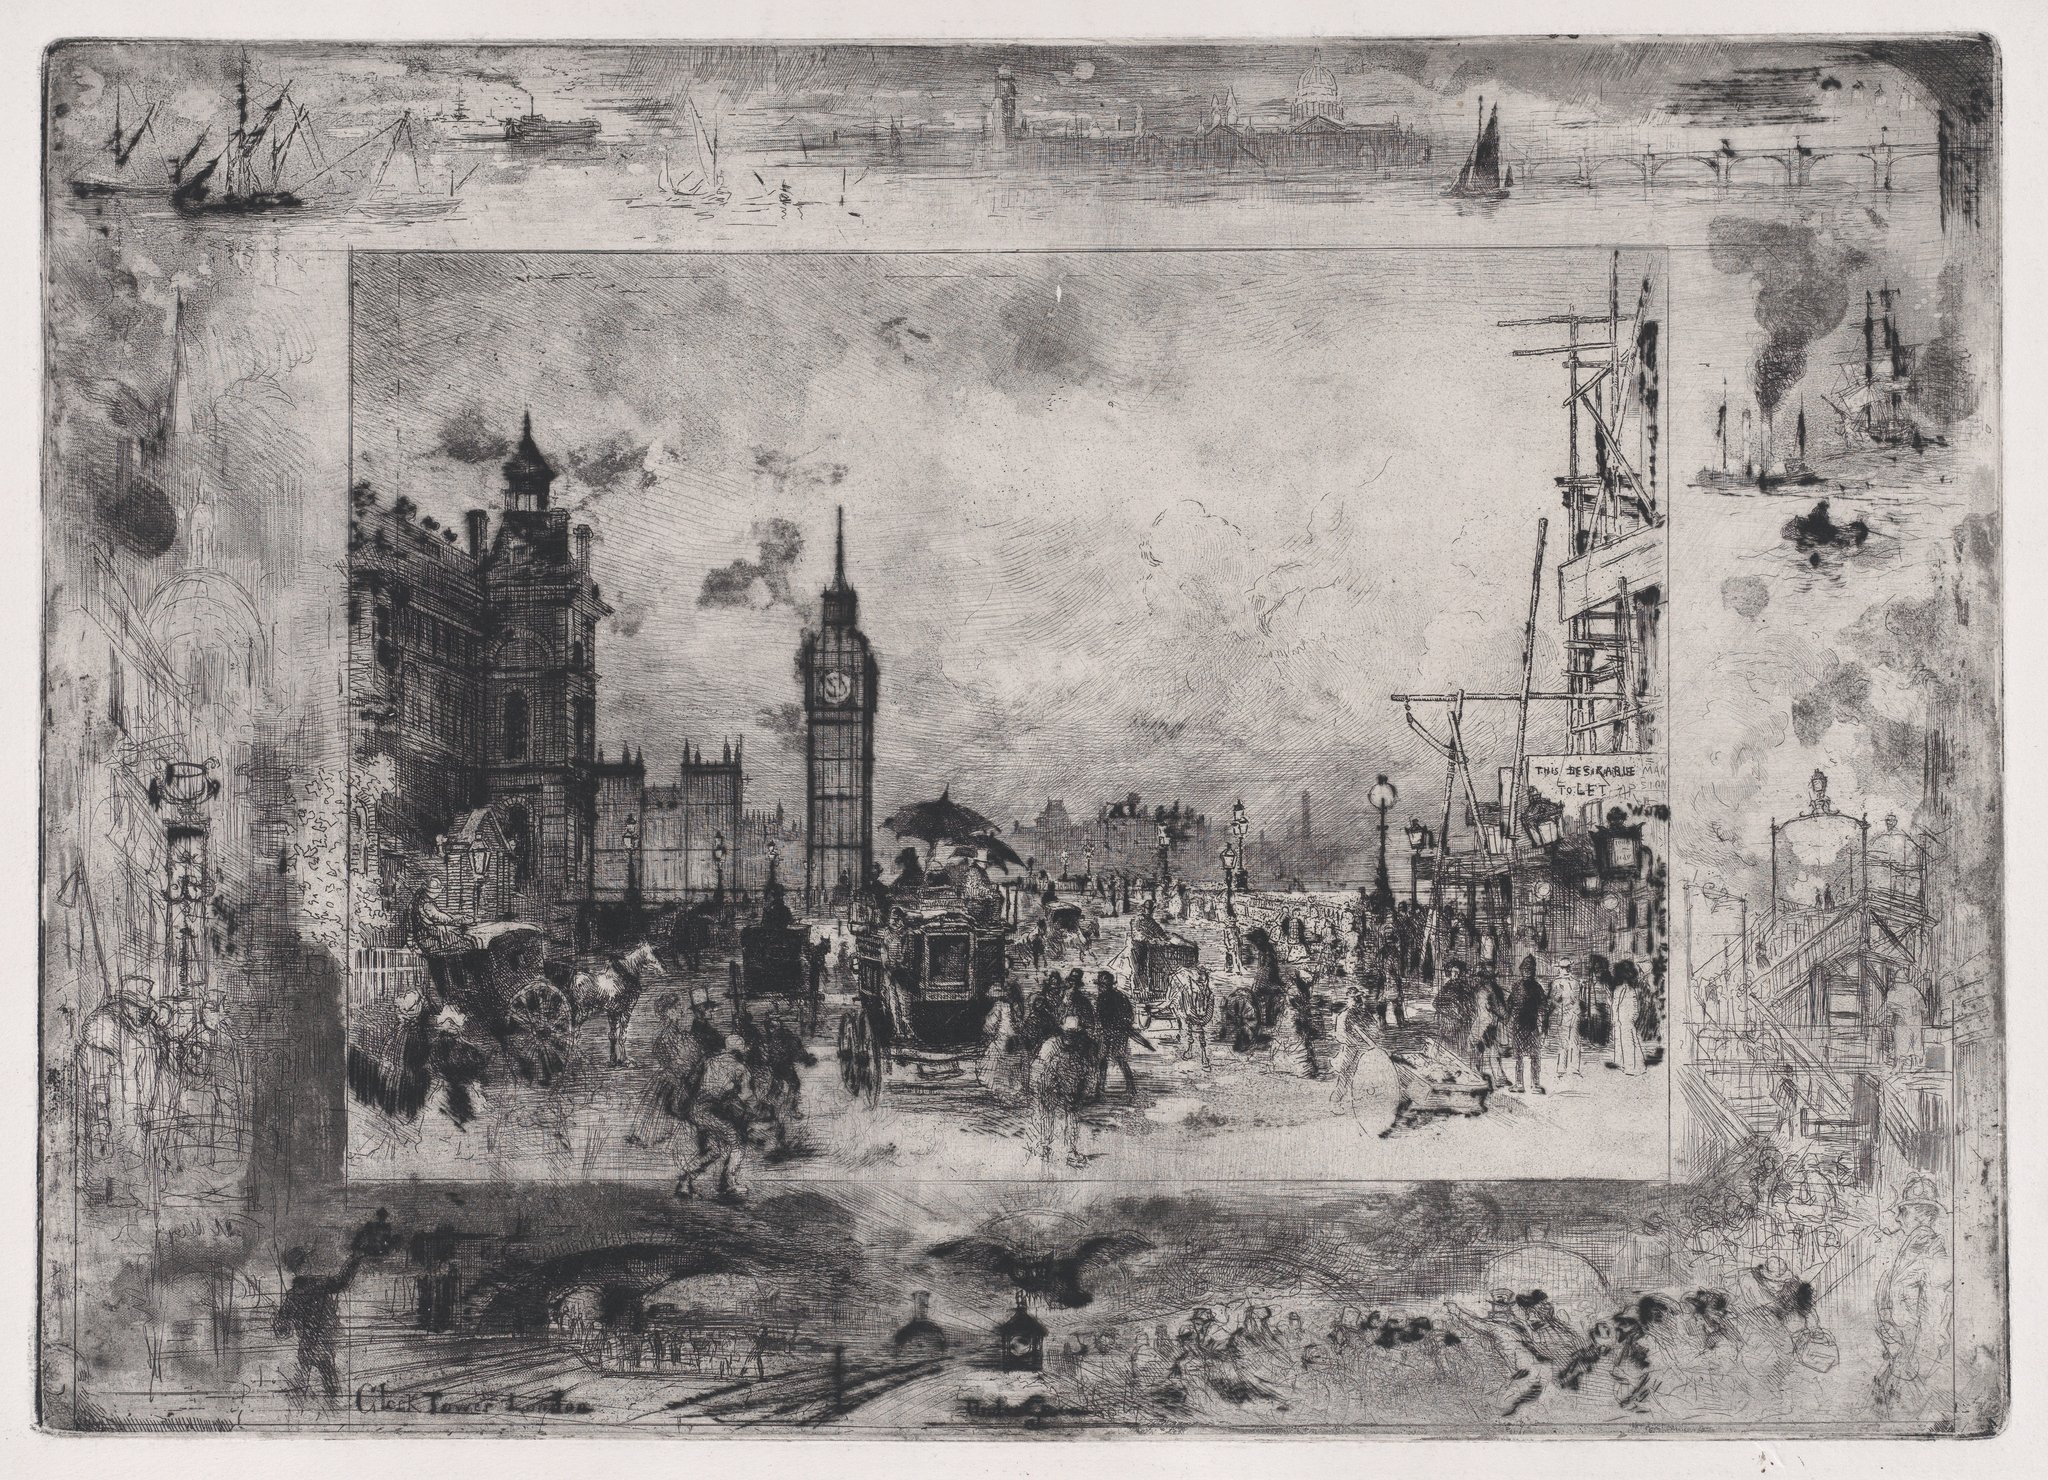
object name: print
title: Westminster Bridge, or Westminster Clock Tower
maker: félix-hilaire buhot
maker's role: artist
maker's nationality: french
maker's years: 1847-1898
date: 1860-1898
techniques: aquatint, drypoint, etching, roulette